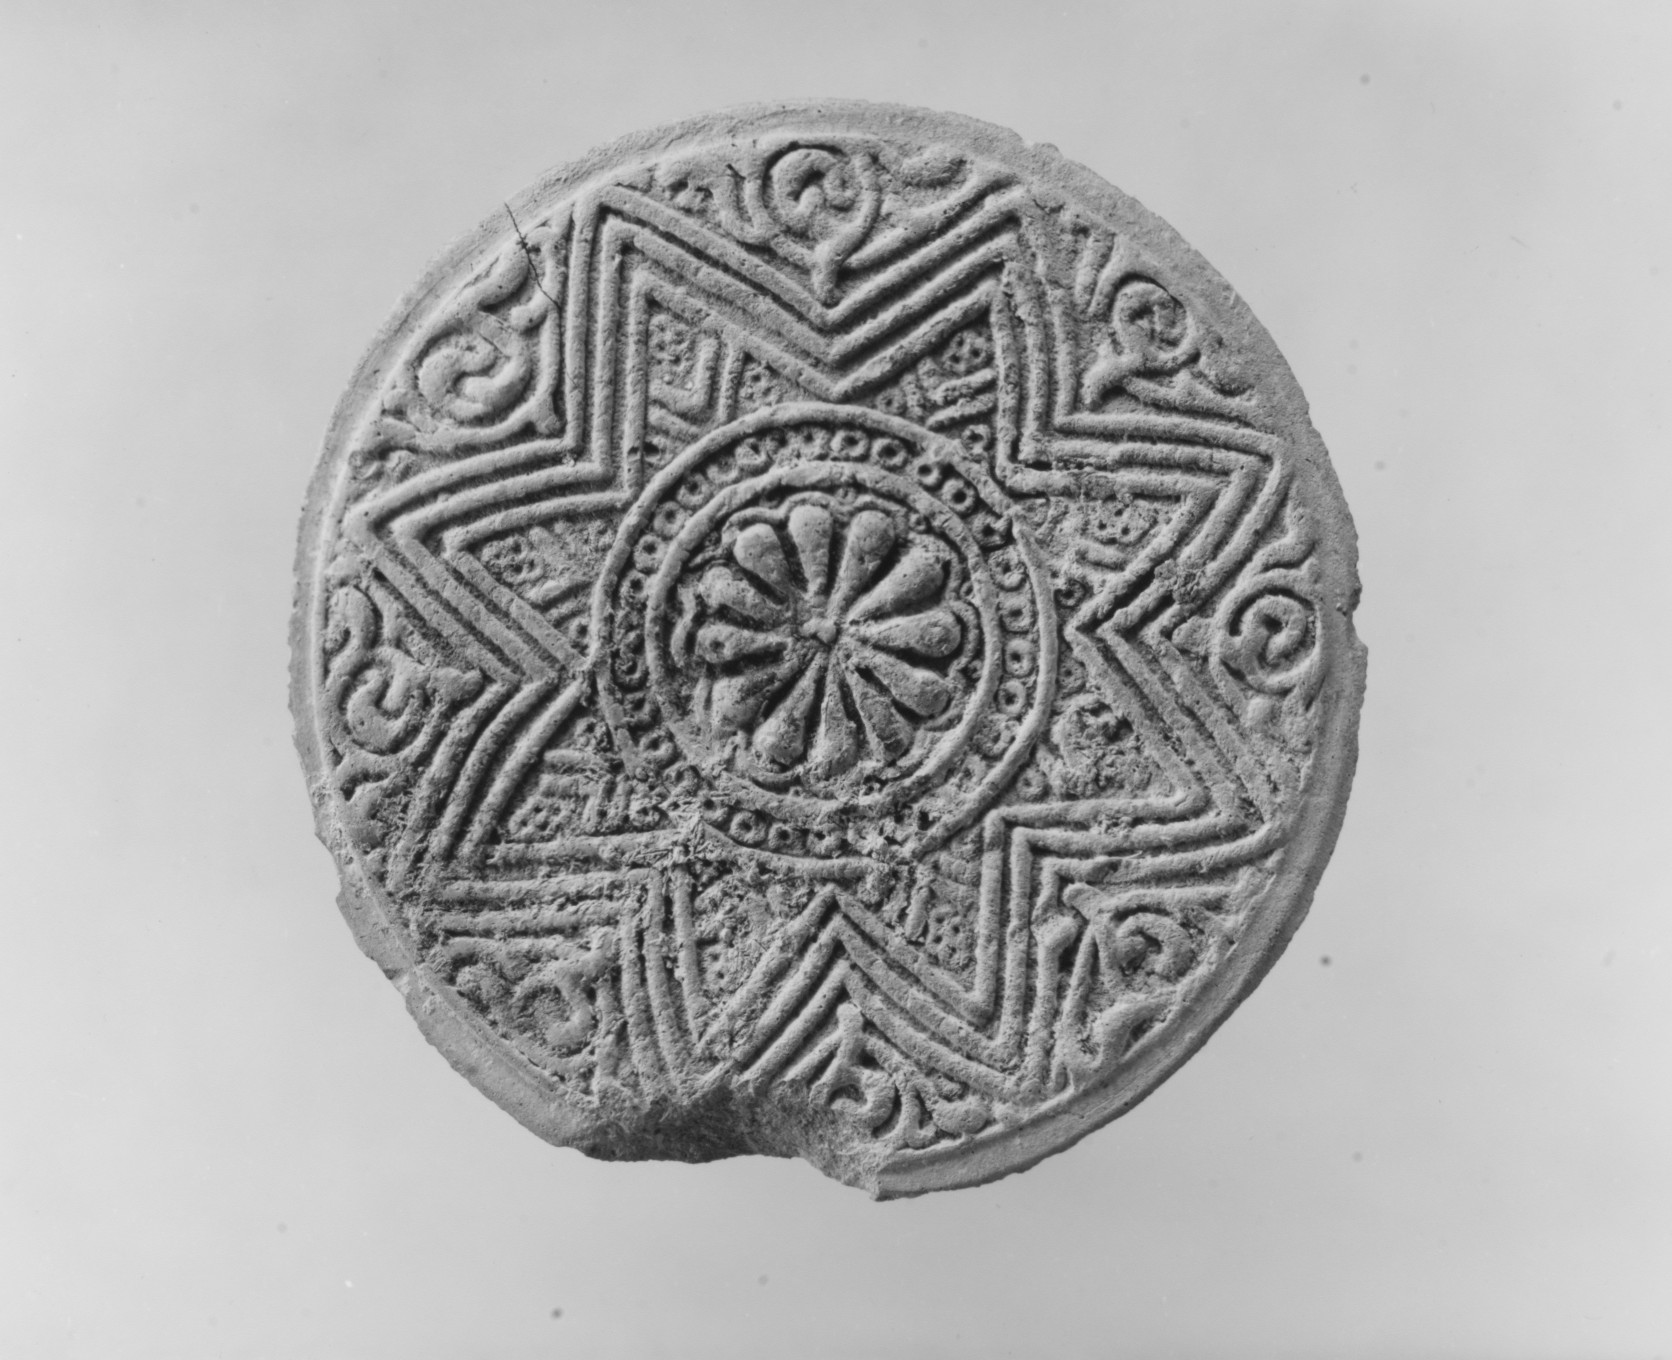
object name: fragment of a jar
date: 1101-1300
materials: earthenware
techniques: molding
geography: syria